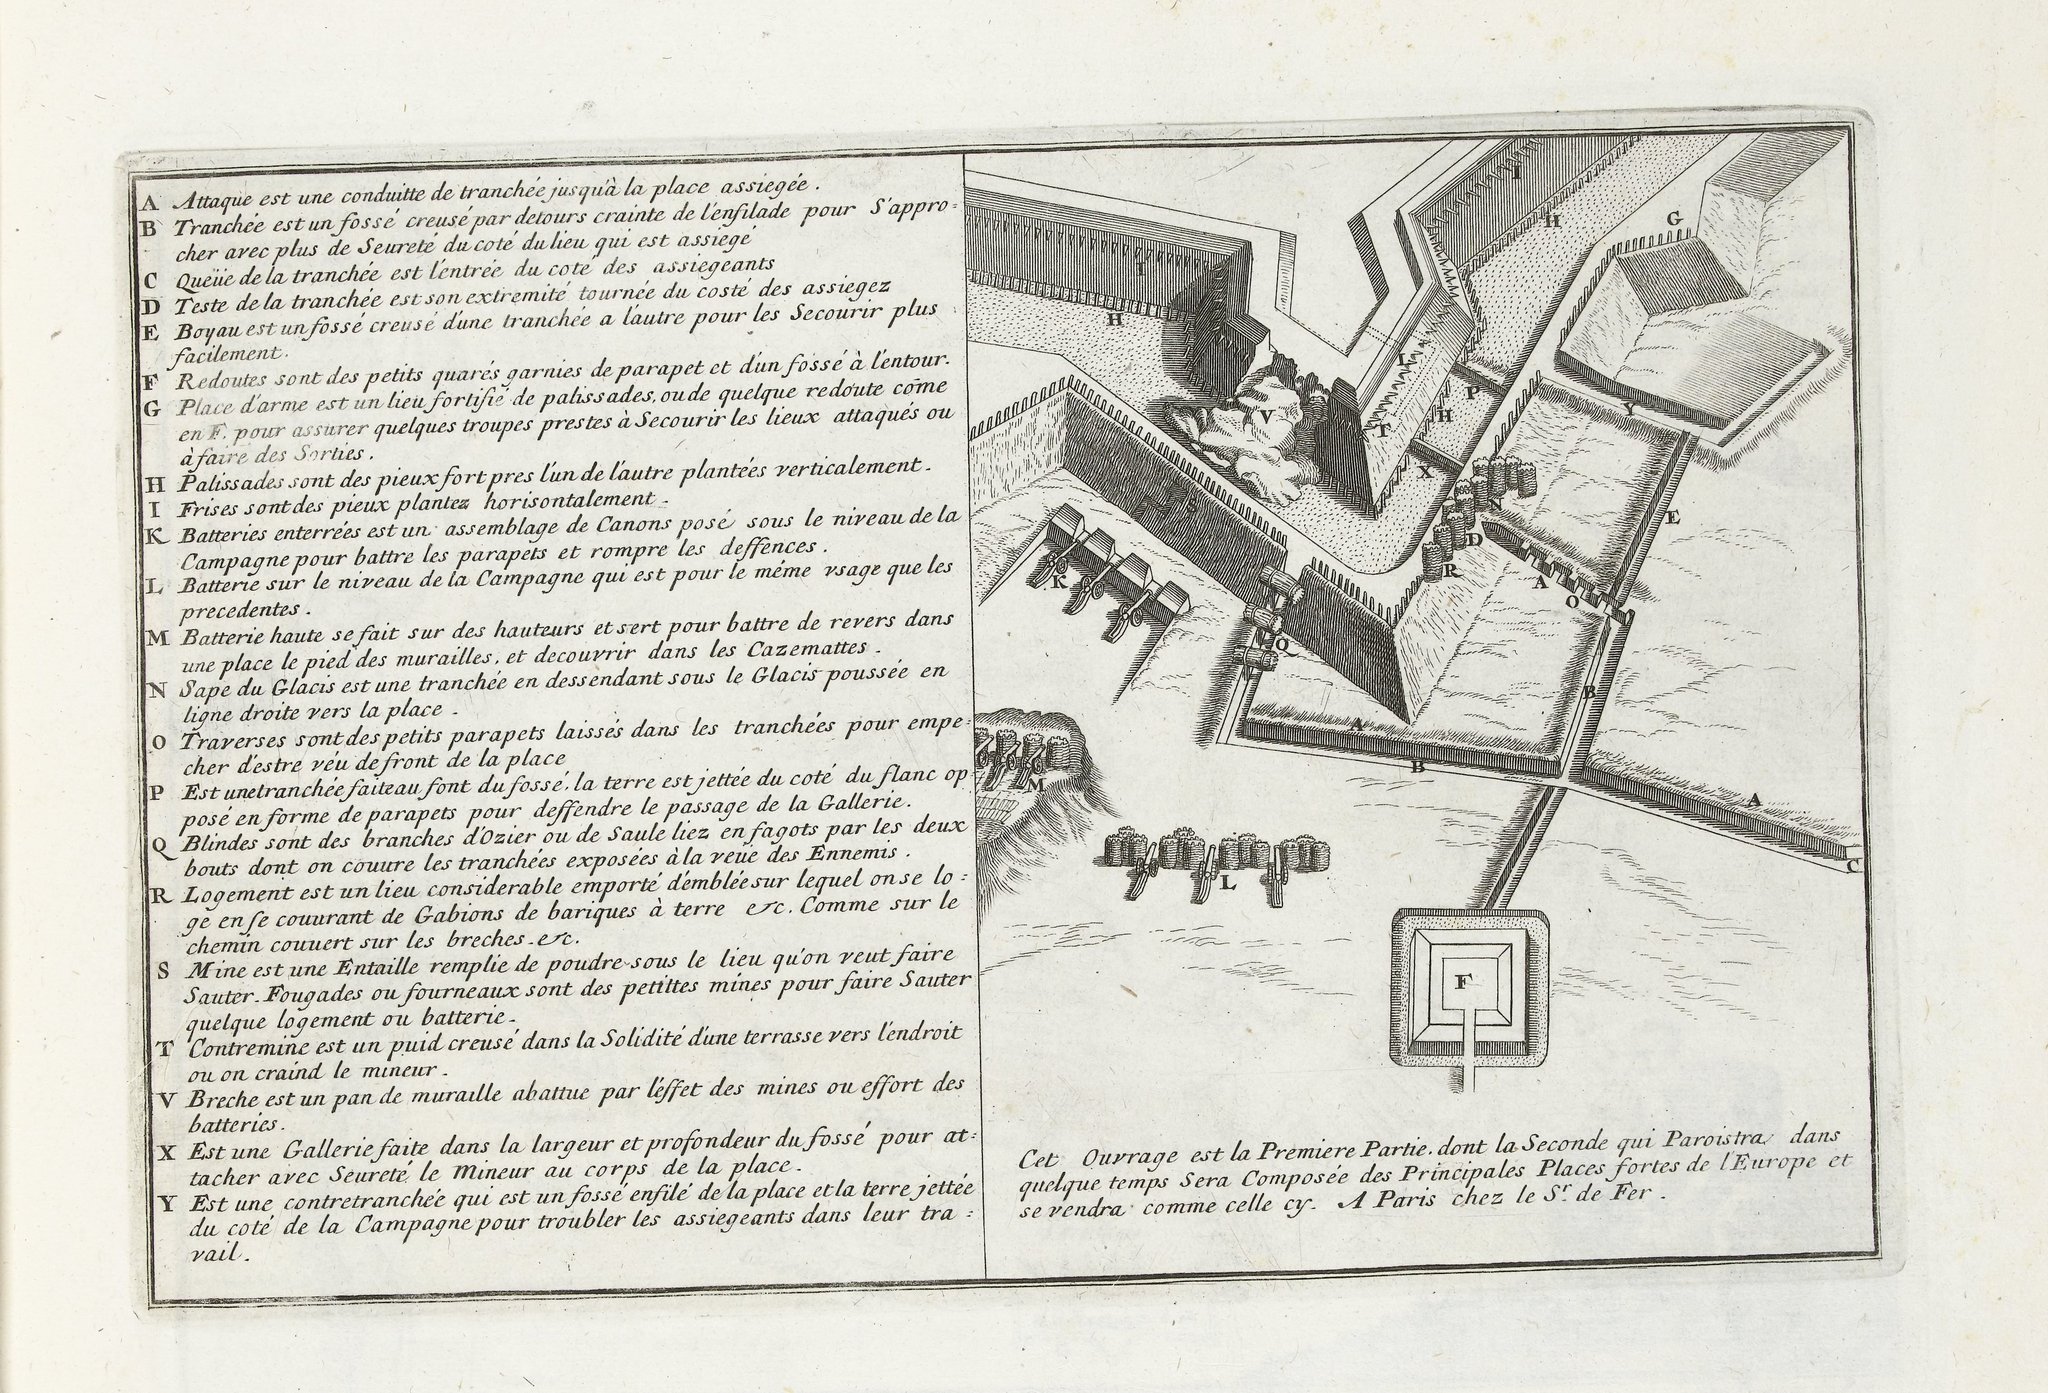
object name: print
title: Achtste plaat met tekst en loopgraven bij een bastion, 1693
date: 1693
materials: paper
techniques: engraving, etching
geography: france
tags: fortifications, military engineering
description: Achtste plaat met tekst en loopgraven bij een bastion. Onderdeel van het eerste deel (1693) van het prentwerk waarin gebundeld zijn de acht delen van Les forces de l'Europe uitgegeven tussen 1693-1697. Het prentwerk bestaat uit 175 platen met plannen (afkomstig van Sébastien Le Prestre, Seigneur de Vauban) van vermaarde sterke steden en vestingen in de Negenjarige Oorlog. Titel in het Frans.